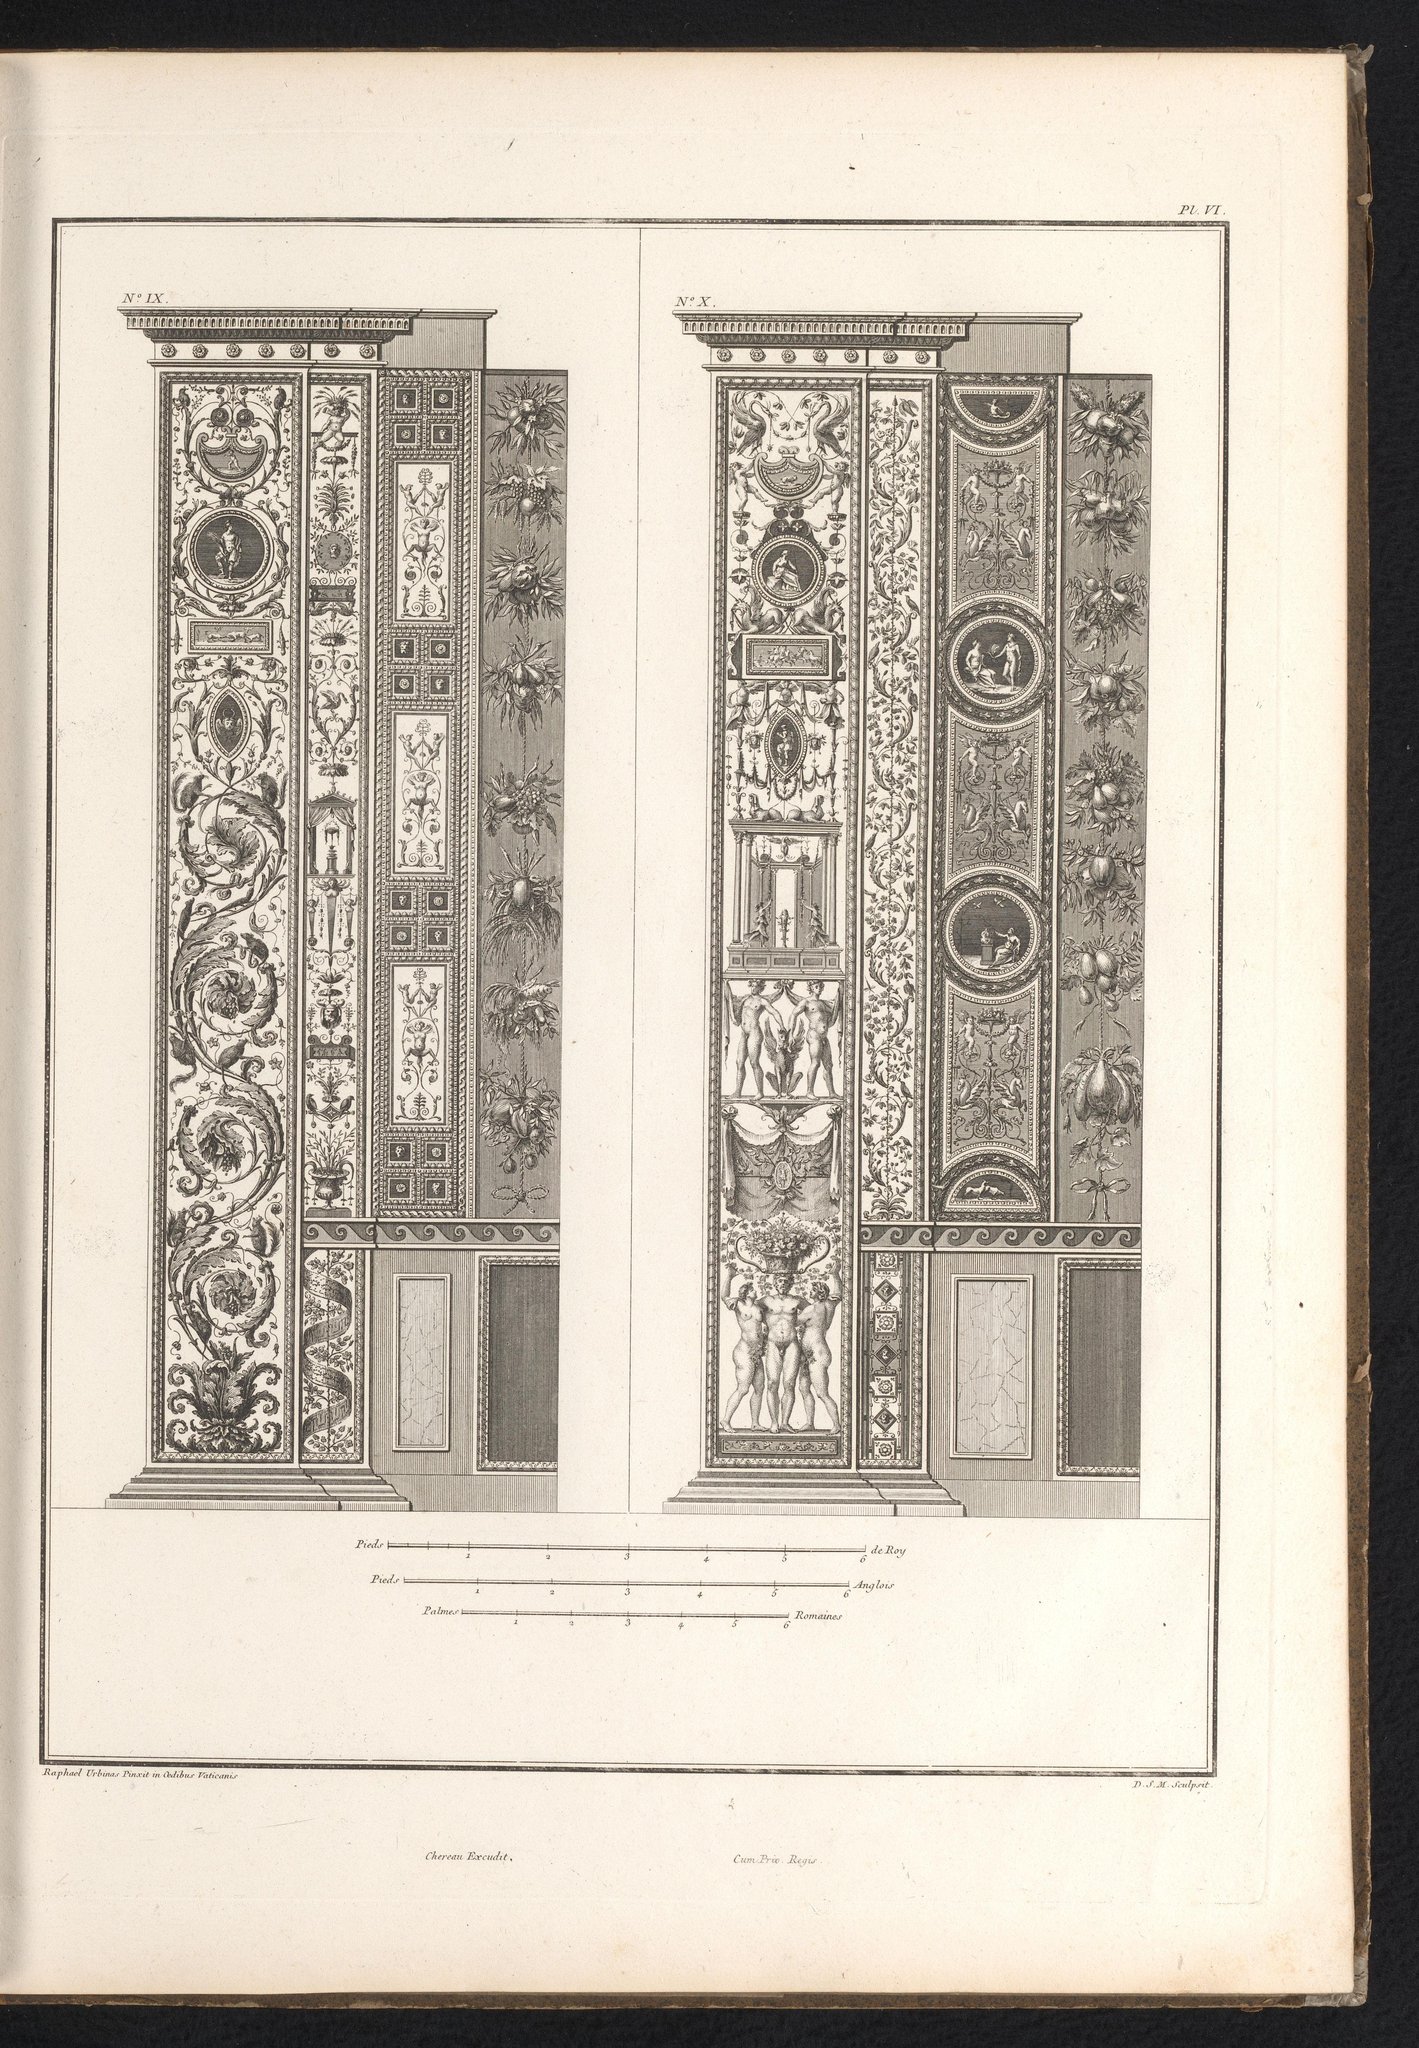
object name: print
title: Wanddecoraties in de Loggia van Rafaël in het Vaticaan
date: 1787-1802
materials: paper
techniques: engraving, etching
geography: paris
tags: panelling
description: Doordat dit album bestaat uit meerdere, deels eerder uitgegeven prentreeksen, is de datering niet consequent. Het geheel is op de titelpagina gedateerd op 1802. Deze reeks, over de Loggia van Rafaël, is gedateerd op 1787. Aangezien onduidelijk is wanneer de prenten in deze vorm precies uitgegeven zijn, worden beide data gehanteerd. De serietitel voor het gehele werk is "Recueil d'arabesques, contenant les loges du Vatican". De andere serietitel is de titel van de specifieke reeks binnen het geheel.